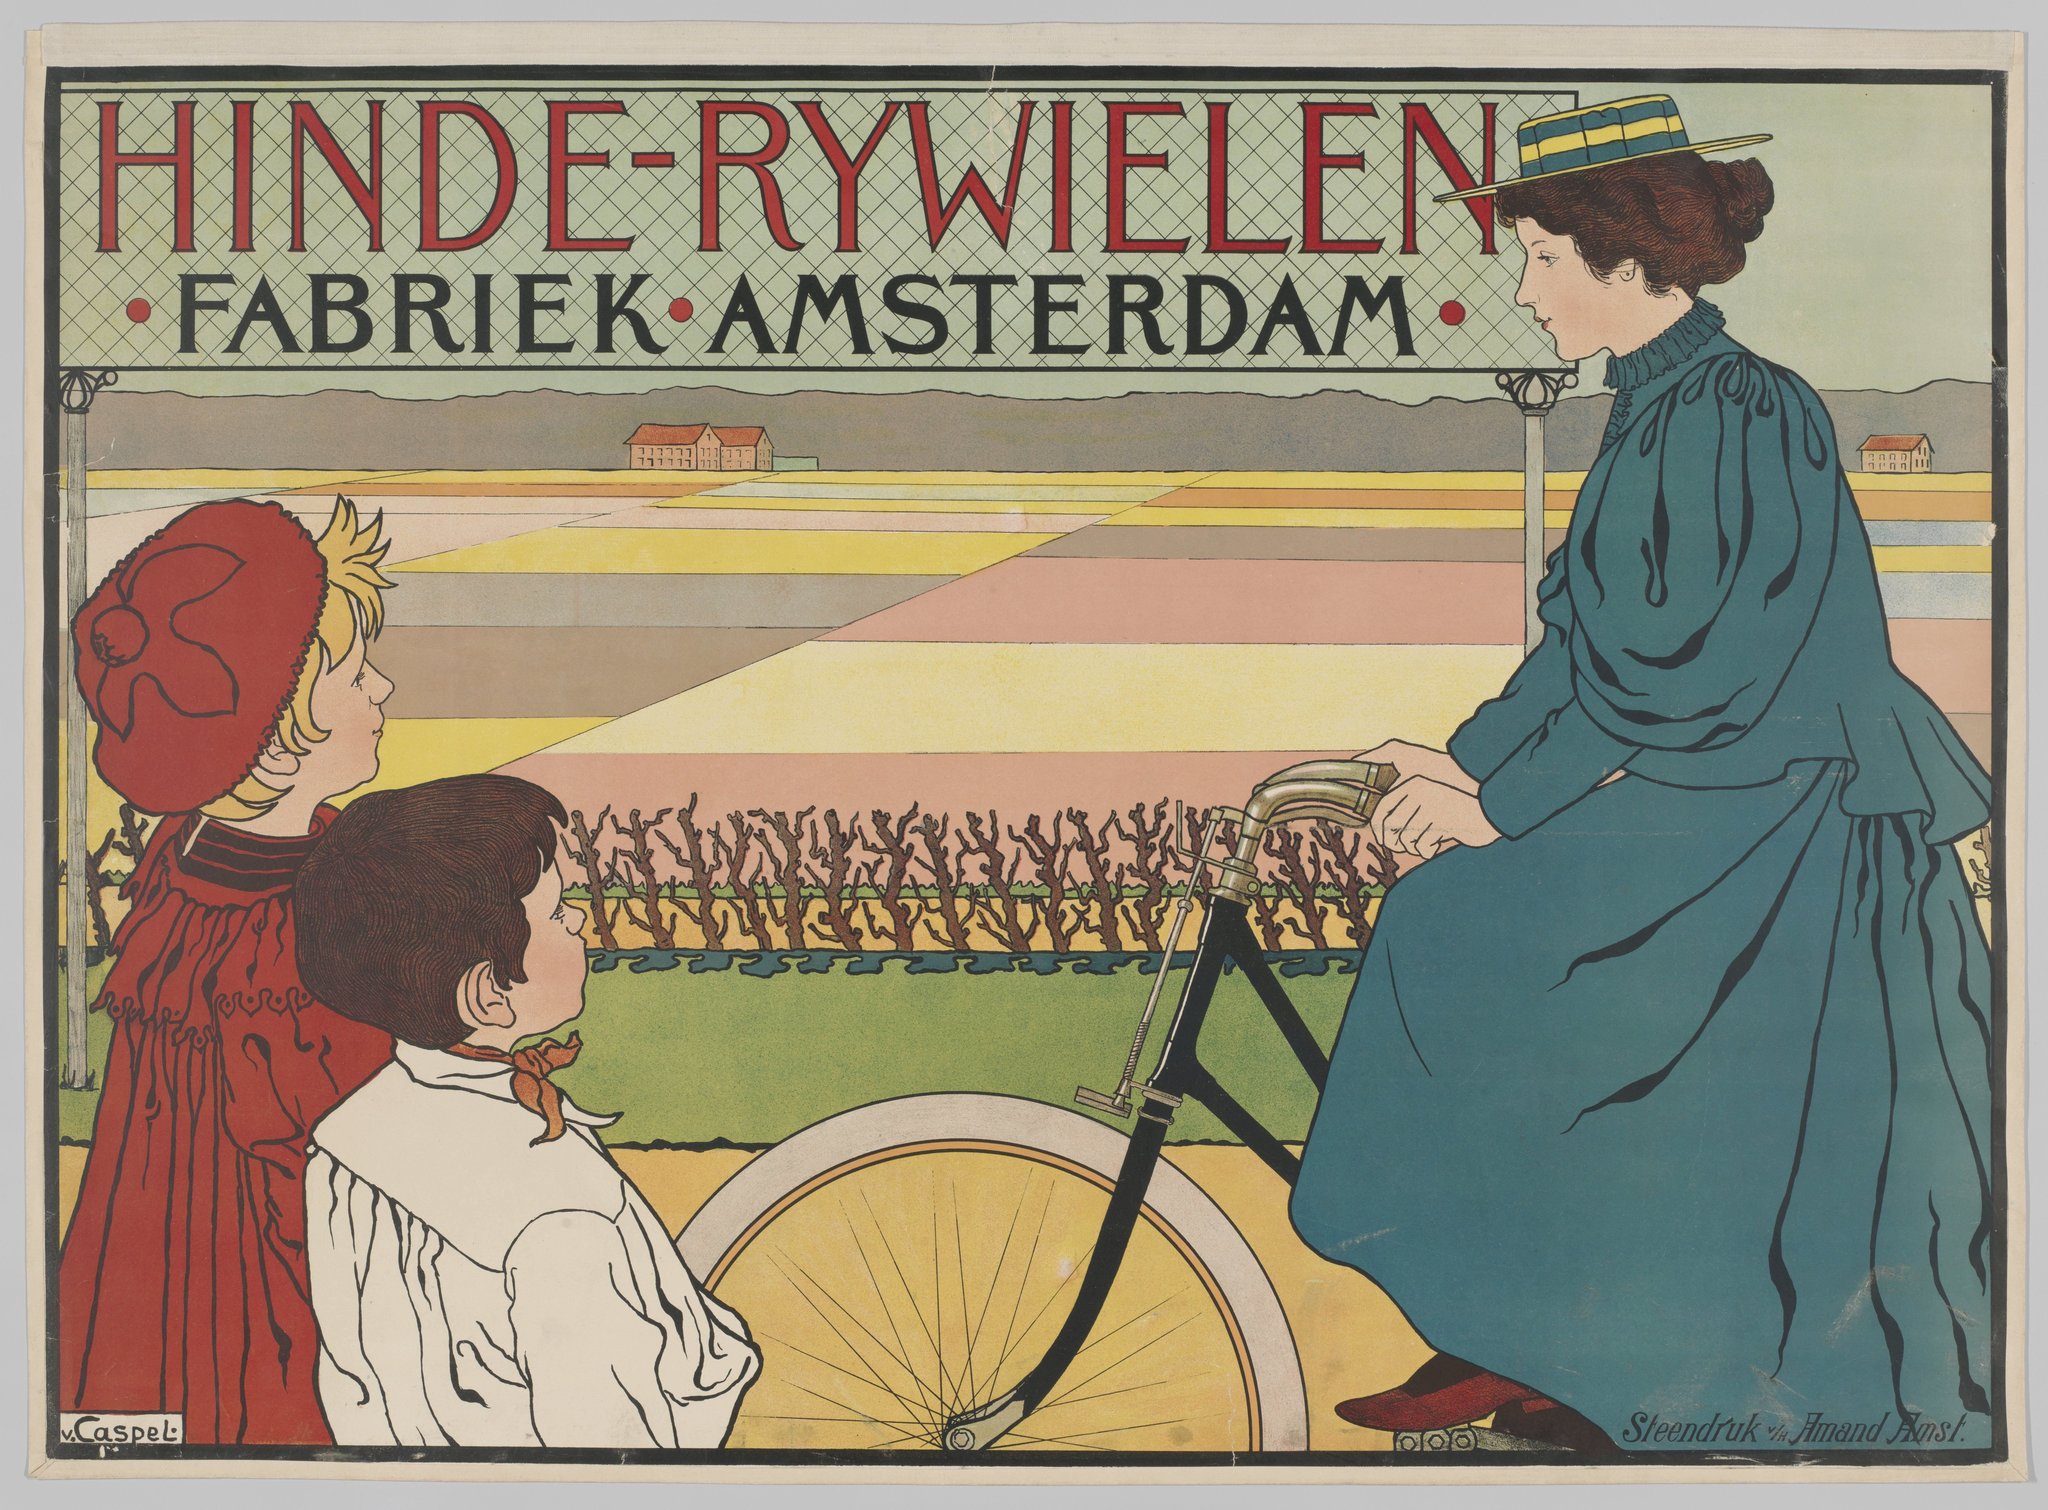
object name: poster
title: Hinde-Rijwielen Fabriek Amsterdam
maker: johann georg van caspel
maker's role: draughtsman, print maker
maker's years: 1870-1928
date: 1896-1898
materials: paper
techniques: lithograph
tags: bicycle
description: Rechts staat een vrouw met een fiets, links staan twee kinderen. Op de achtergrond een landschap.